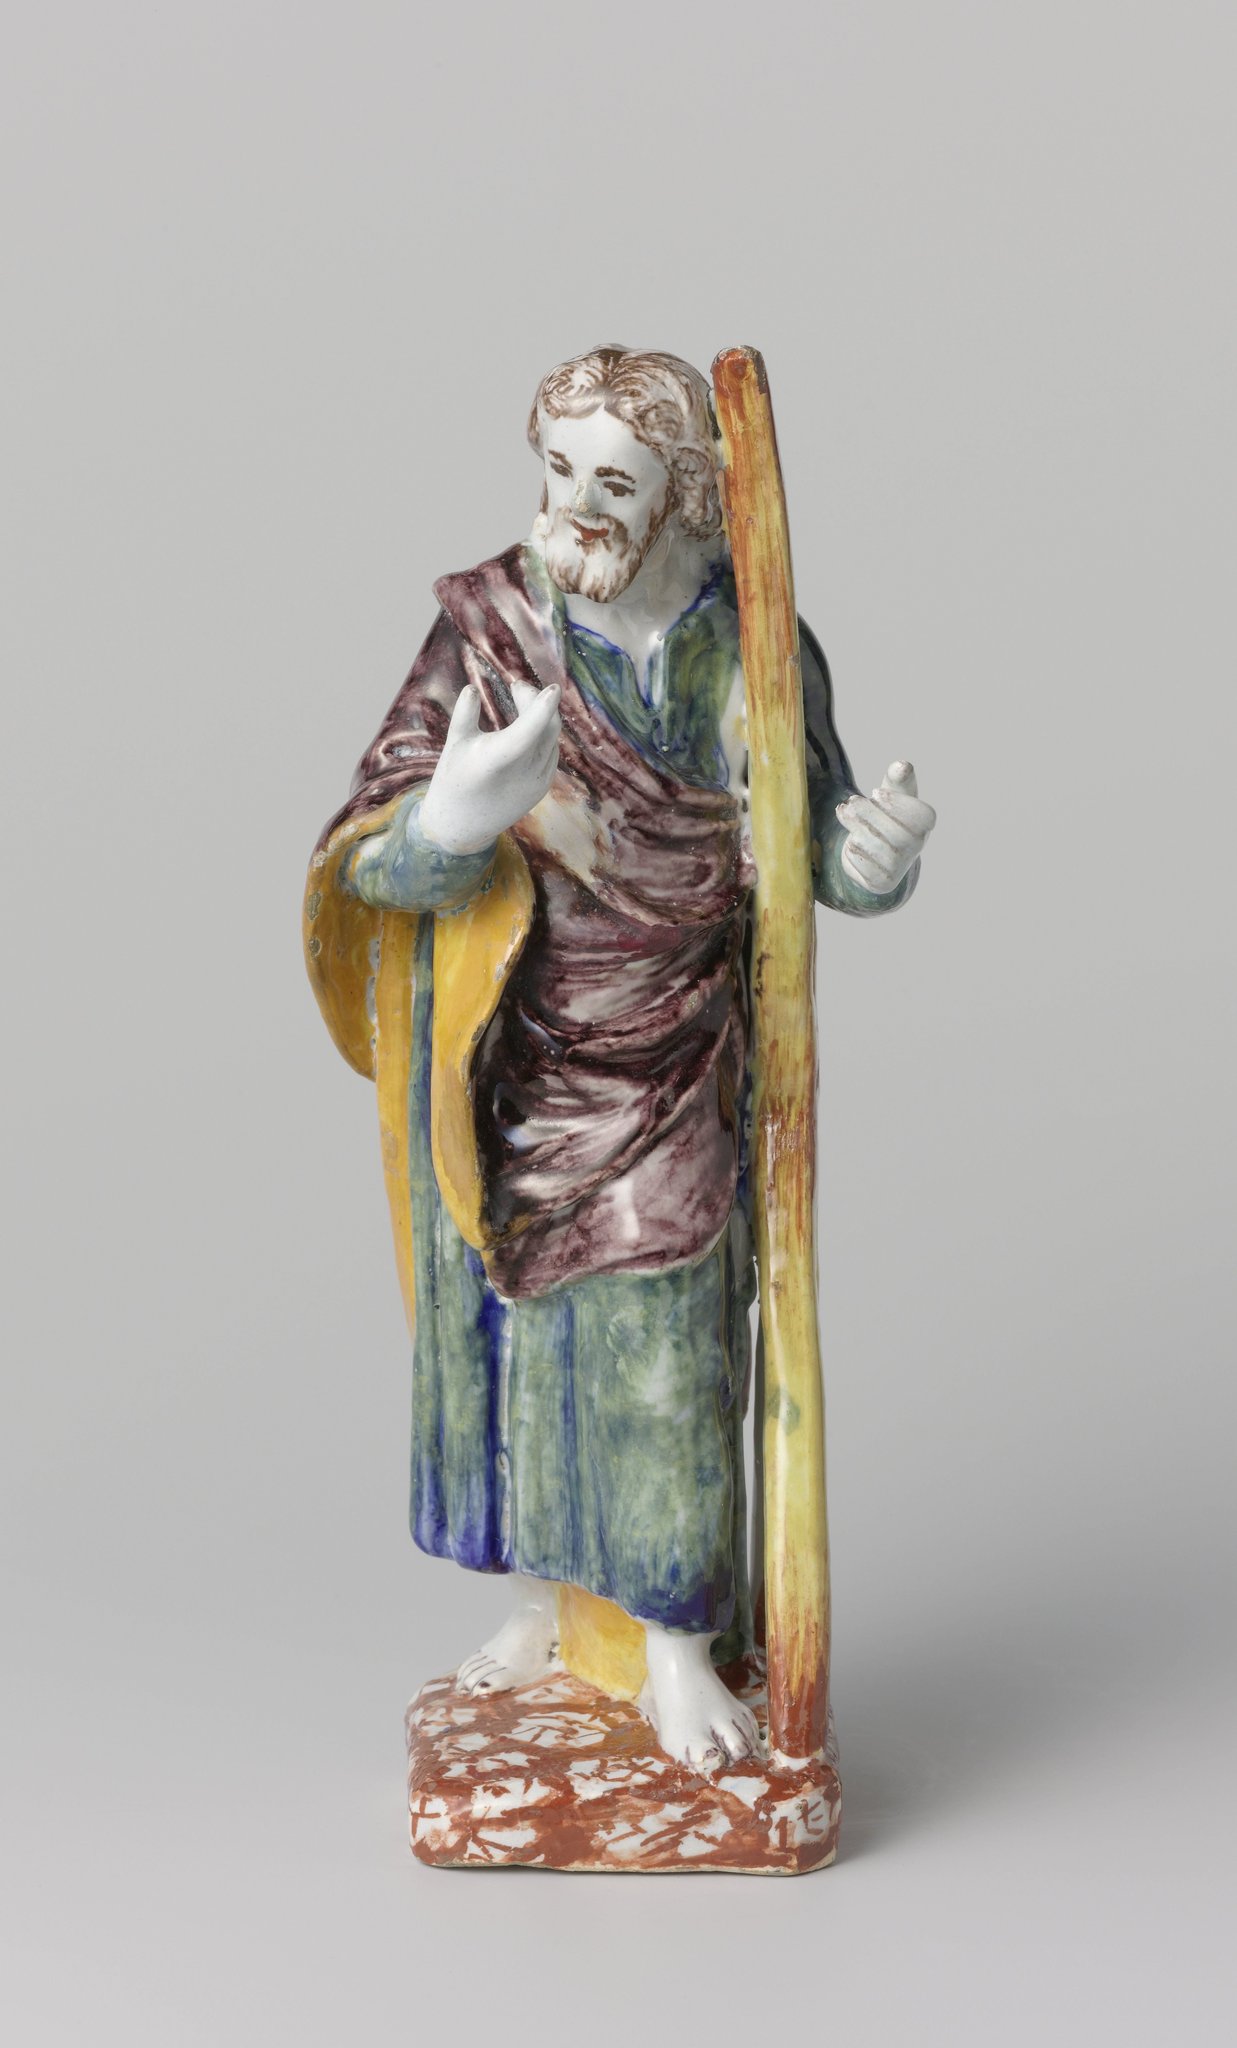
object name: mannenfiguur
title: Mannenfiguur van faience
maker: Anonymous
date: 1760-1785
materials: faience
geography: delft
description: Mannenfiguur van faience, voorstellende een apostel (Andreas) die naast zijn kruis staat. Veelkleurig beschilderd.